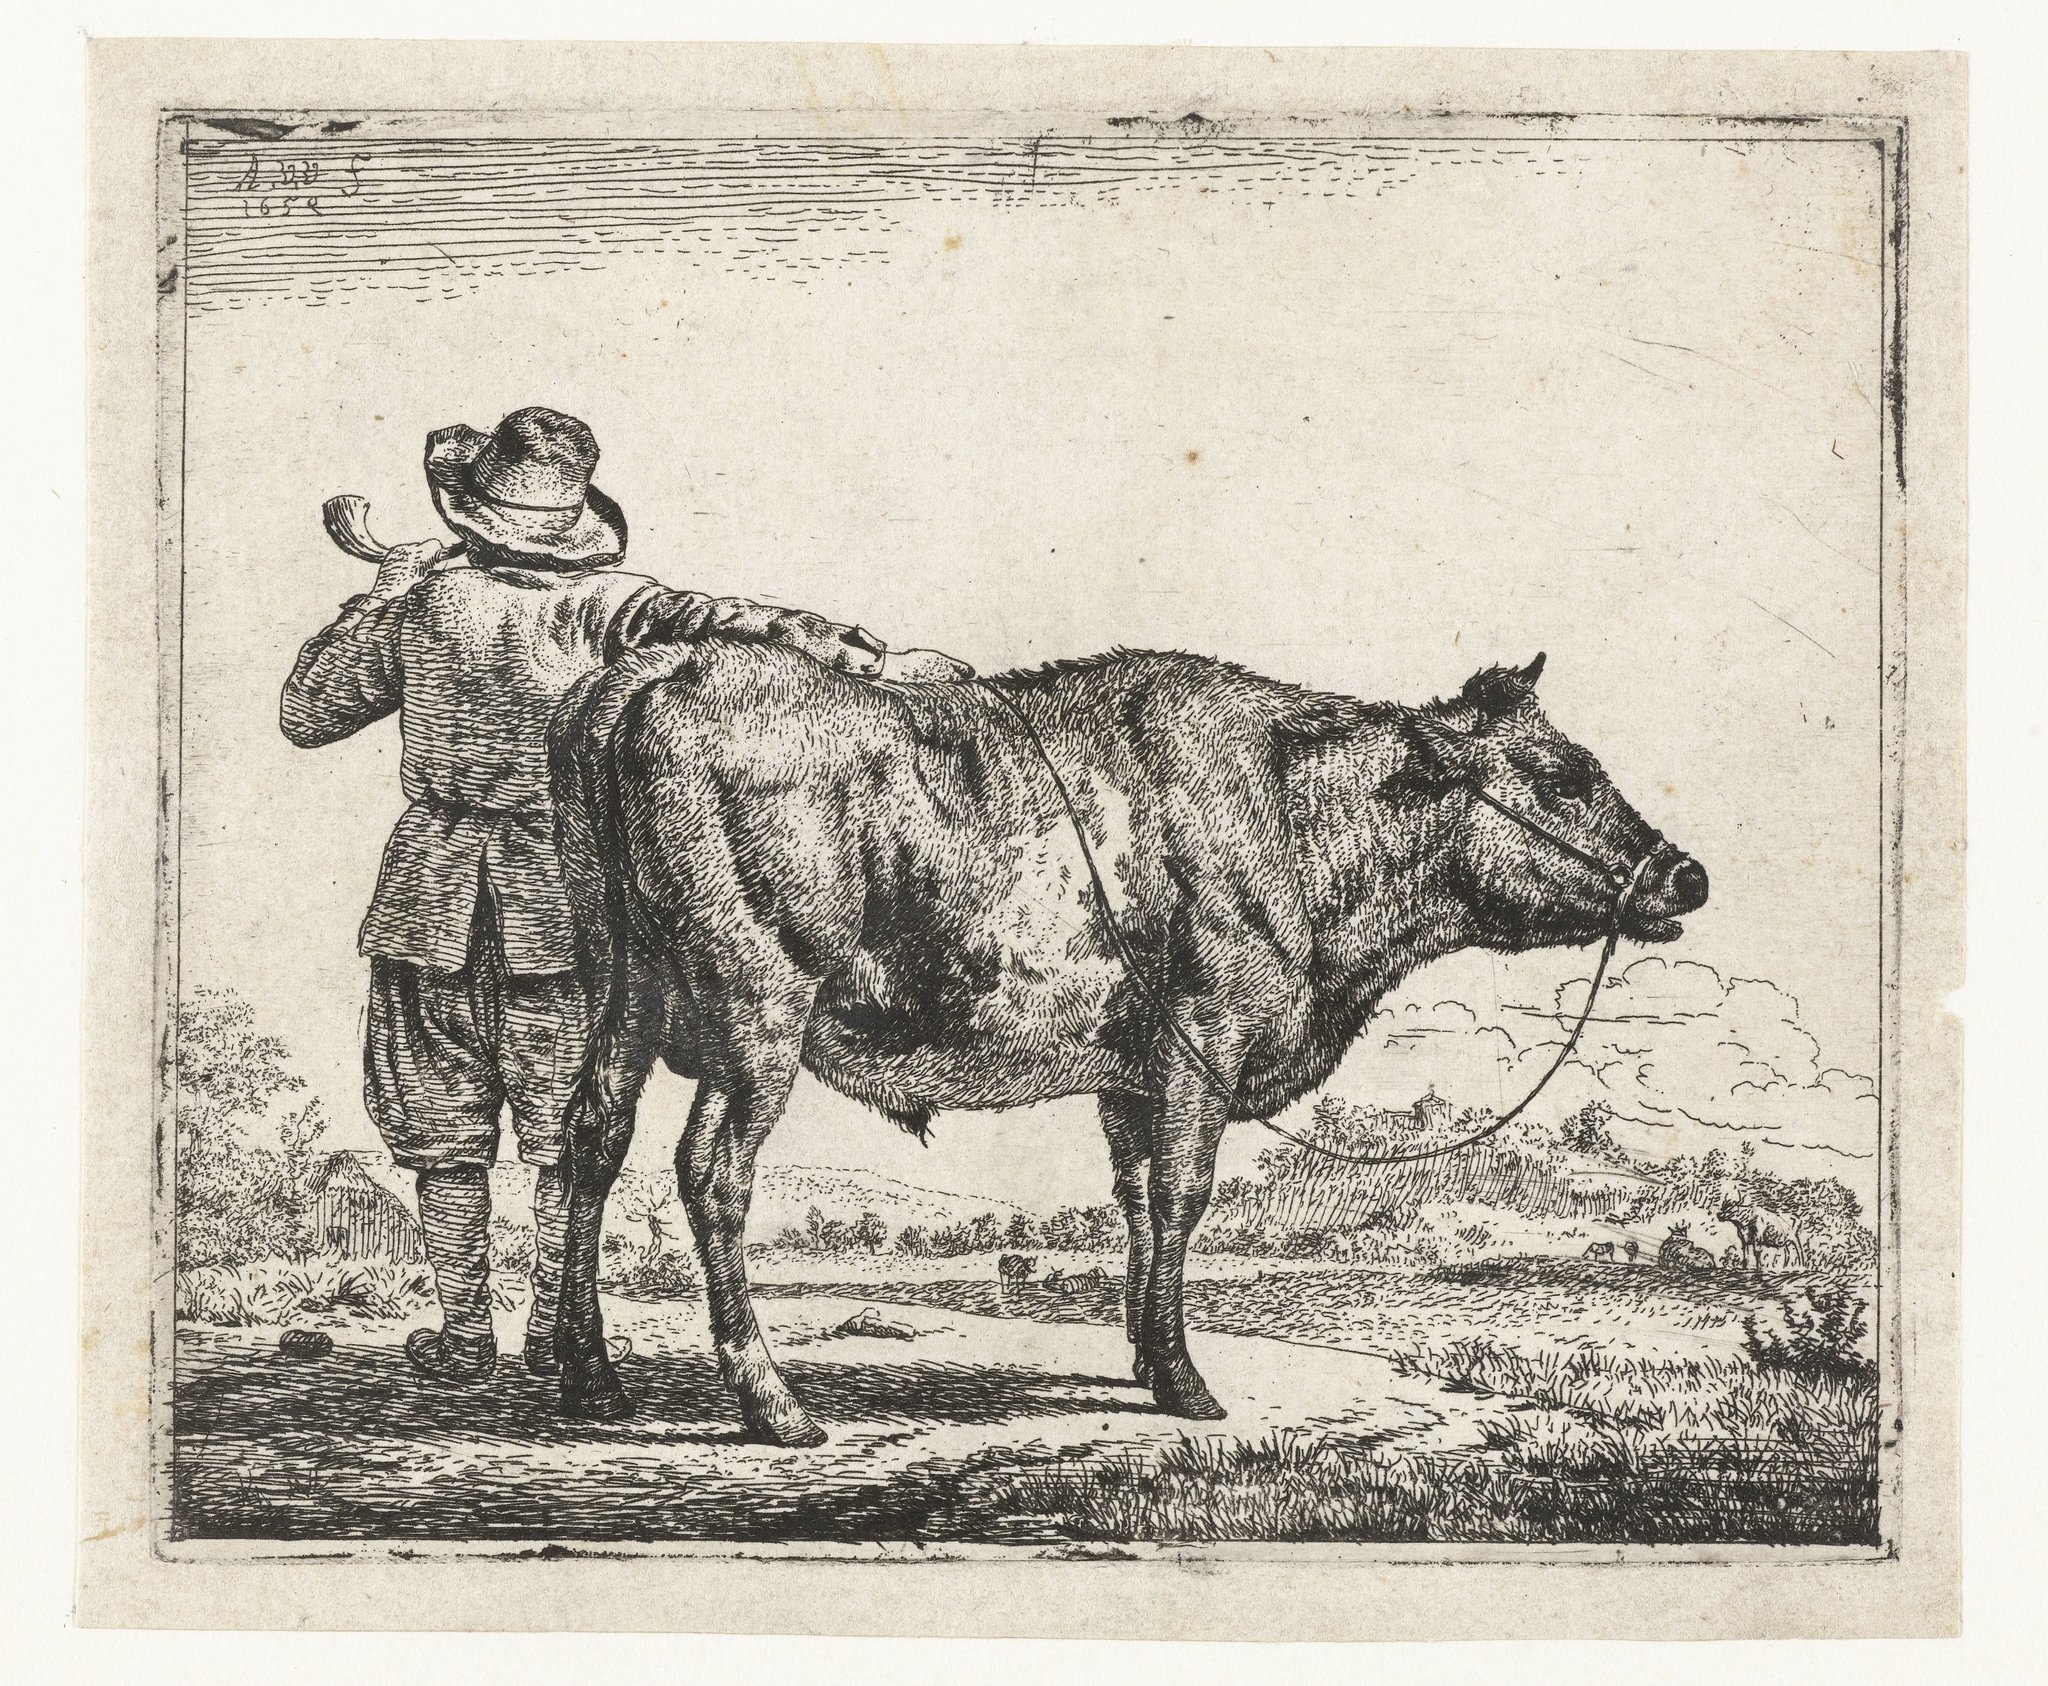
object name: print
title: Jonge herder met een stier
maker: adriaen van de velde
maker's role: draughtsman, painter, print maker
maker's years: 1636-1672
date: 1659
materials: paper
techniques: etching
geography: amsterdam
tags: bull, herding, herdsman, herdswoman, shepherd, shepherdess, cowherd, etc.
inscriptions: collector's mark: Lugt 240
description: Eerste prent uit een serie van tien prenten met verschillende dieren. Van de Velde nam het thema met de jonge herder en de stier over van een vroeg schilderij van Jacob Isaacksz. van Ruisdael uit 1646. In het landschap met een boerderij van Ruisdael zijn de herder en de stier met de opvallende witte vlek op de flank klein in de compositie geplaatst. Van de Velde maakte het groepje los uit de oorspronkelijke context en volgde bij zijn weergave nauwkeurig ieder detail. De herder die op zijn hoorn blaast terwijl hij de stier aan een touw vasthoudt staan groot op de voorgrond in een licht glooiend landschap.